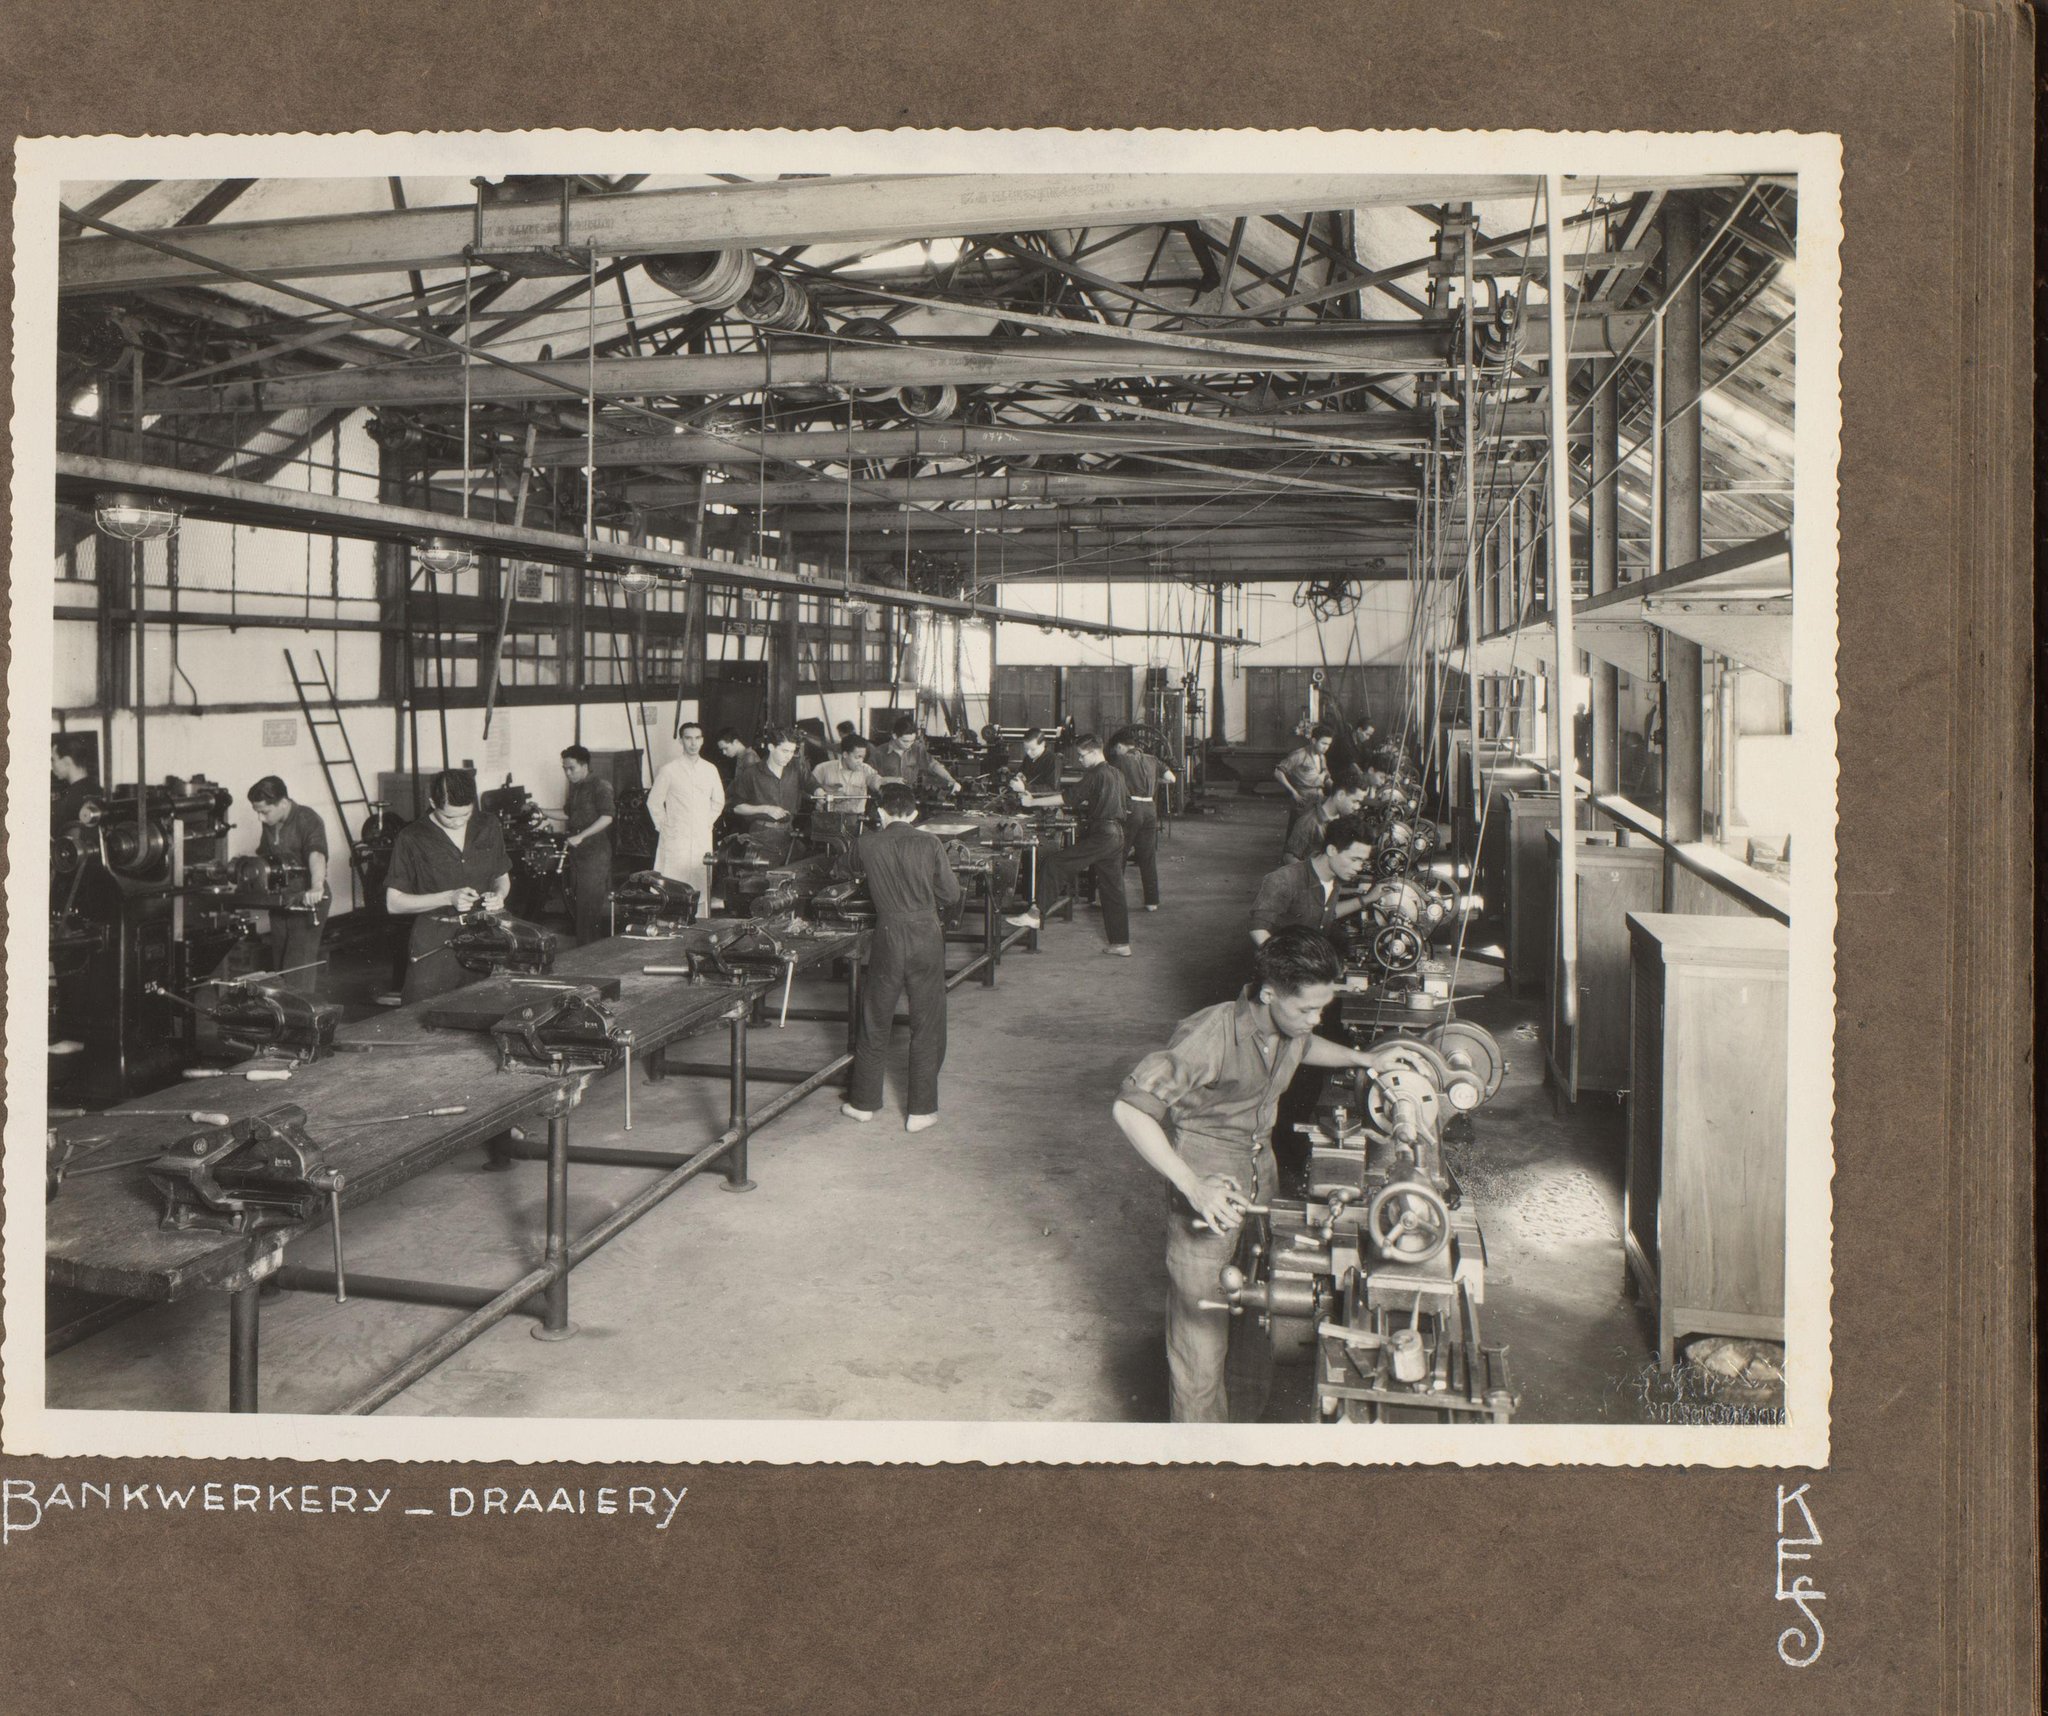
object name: photograph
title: Bankwerkerij in de Koningin Emma School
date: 1933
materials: photographic support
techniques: gelatin silver print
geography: surabaya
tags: vocational education, e.g.: junior technical school, colonial government, dutch east indies, the, surabaya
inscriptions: inscription: ‘Bankwerkery of Draaiery / KES’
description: Gezicht in de bankwerkerij of draaierij in de Koningin Emma School te Soerabaja waar leerlingen onder toezicht van een docent aan het werk zijn. Foto ingeplakt in het fotoalbum aangeboden aan J.H.A. van der Hoeven bij het beëindigen op 31 juli 1933 van zijn diensttijd bij het Nijverheidsonderwijs in Nederlandsch-Indië.